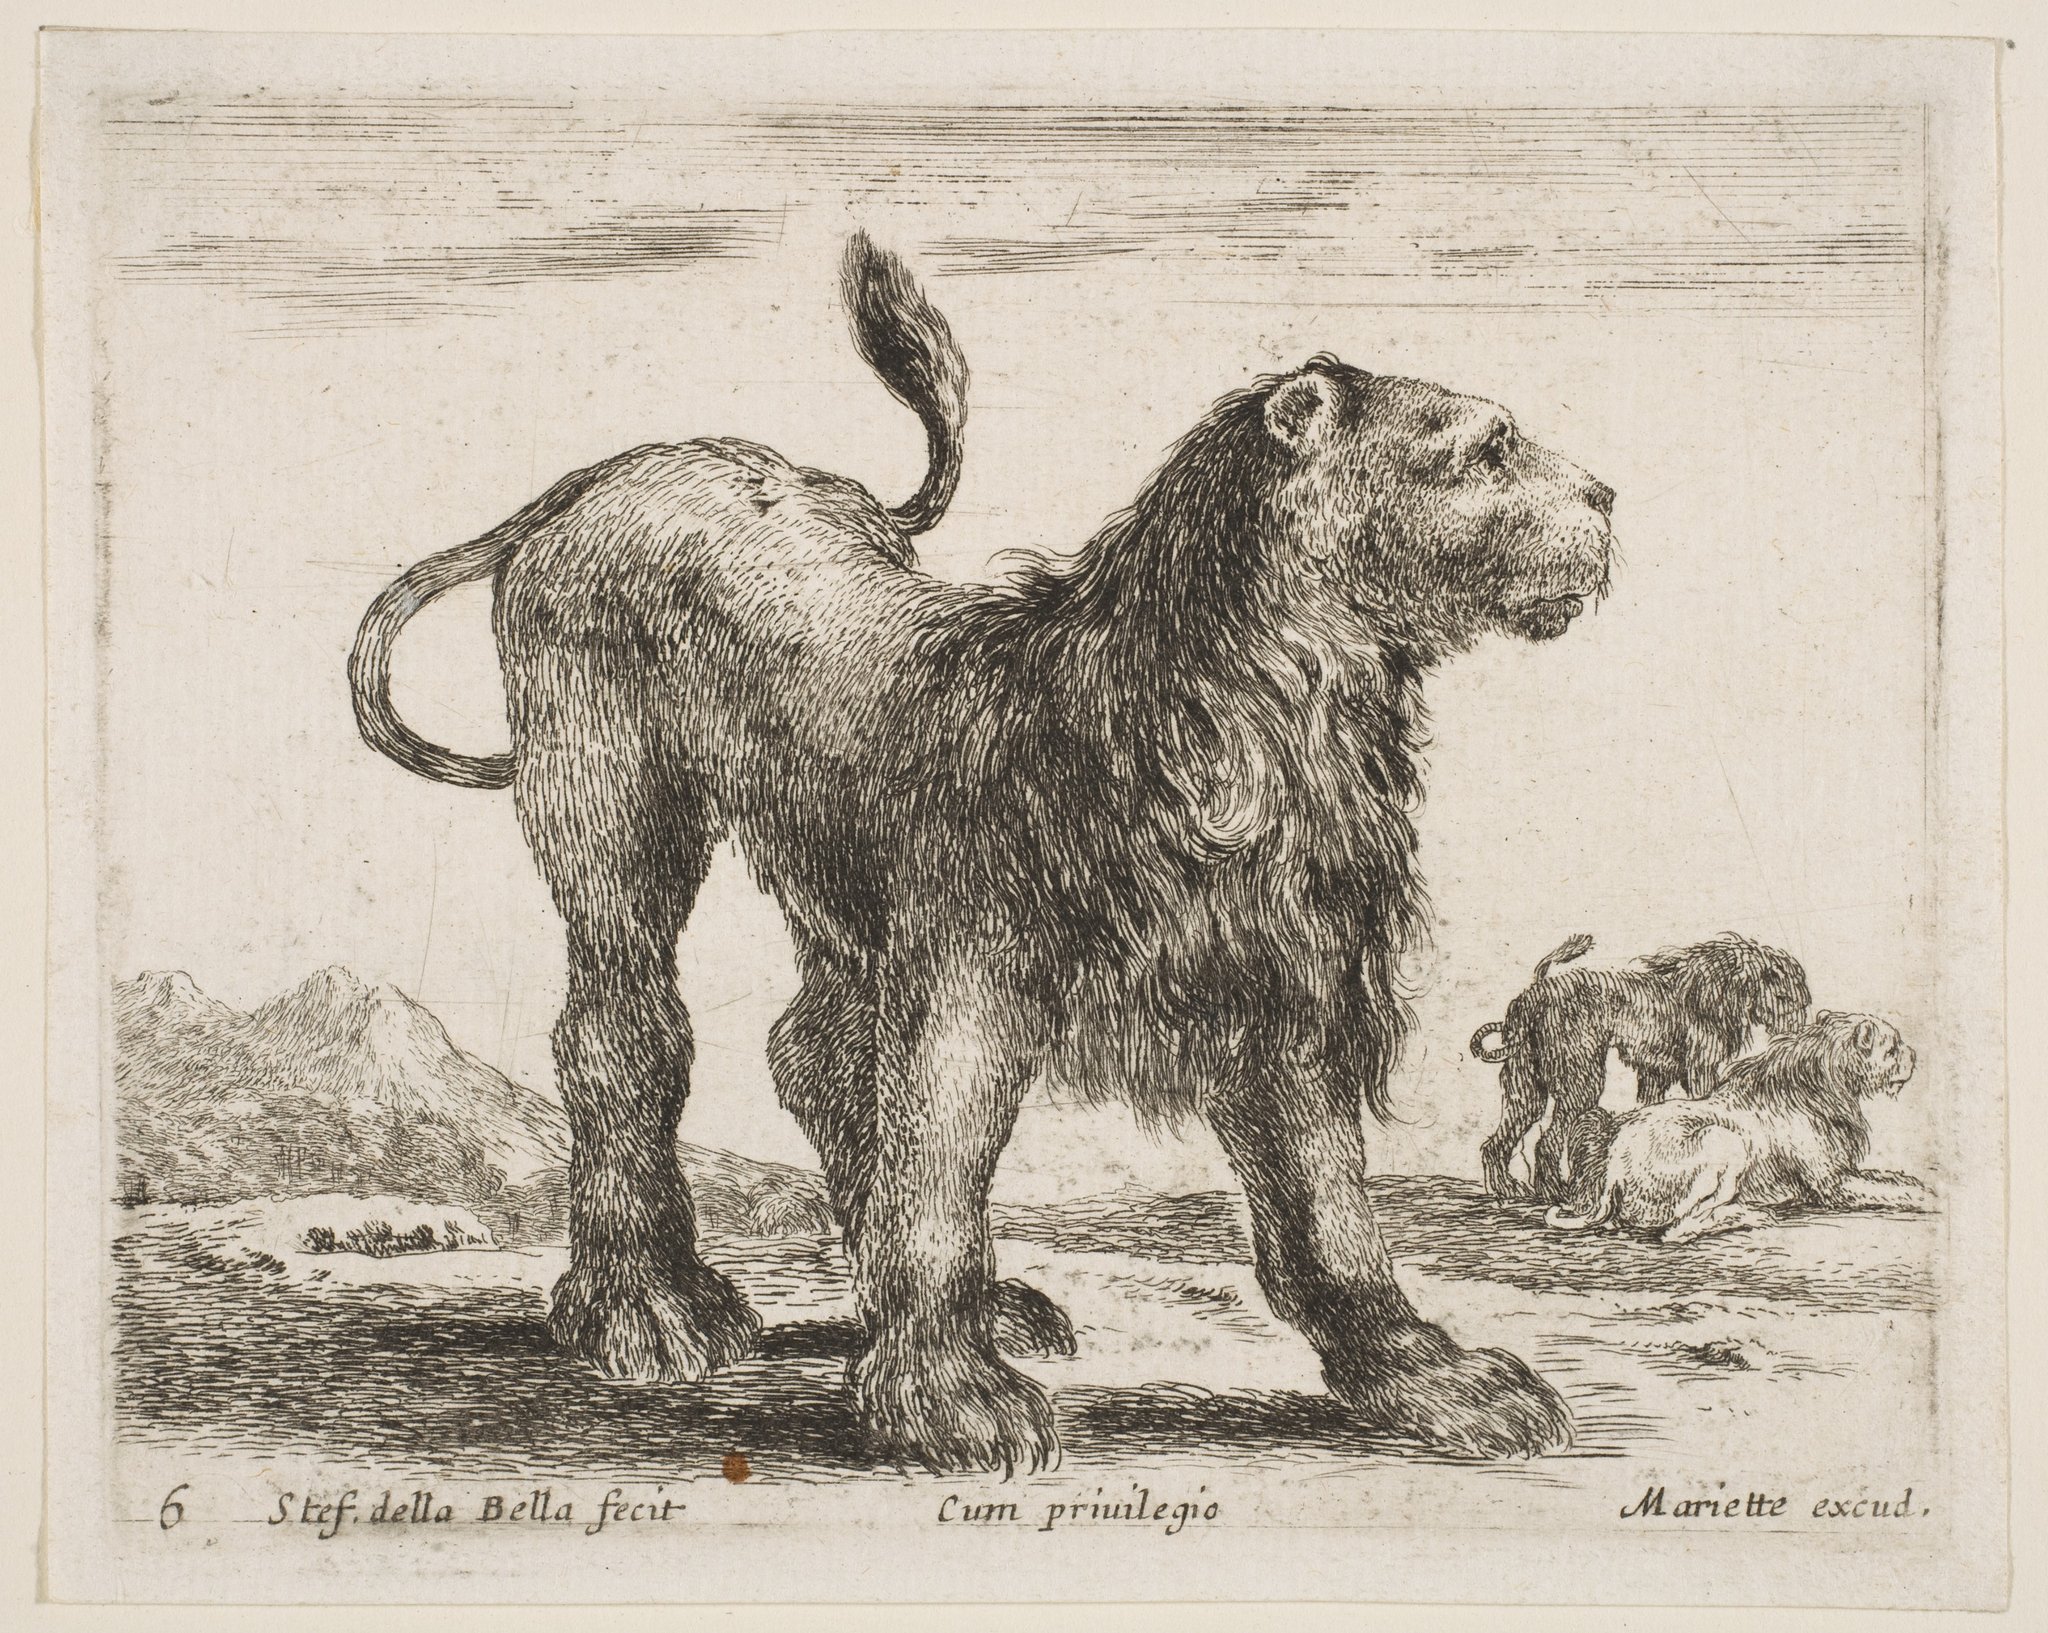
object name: print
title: Lion, plate 6 from "Various Animals" (Diversi Animali)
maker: stefano della bella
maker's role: artist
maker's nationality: italian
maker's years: 1610-1664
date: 1641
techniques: etching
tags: lions